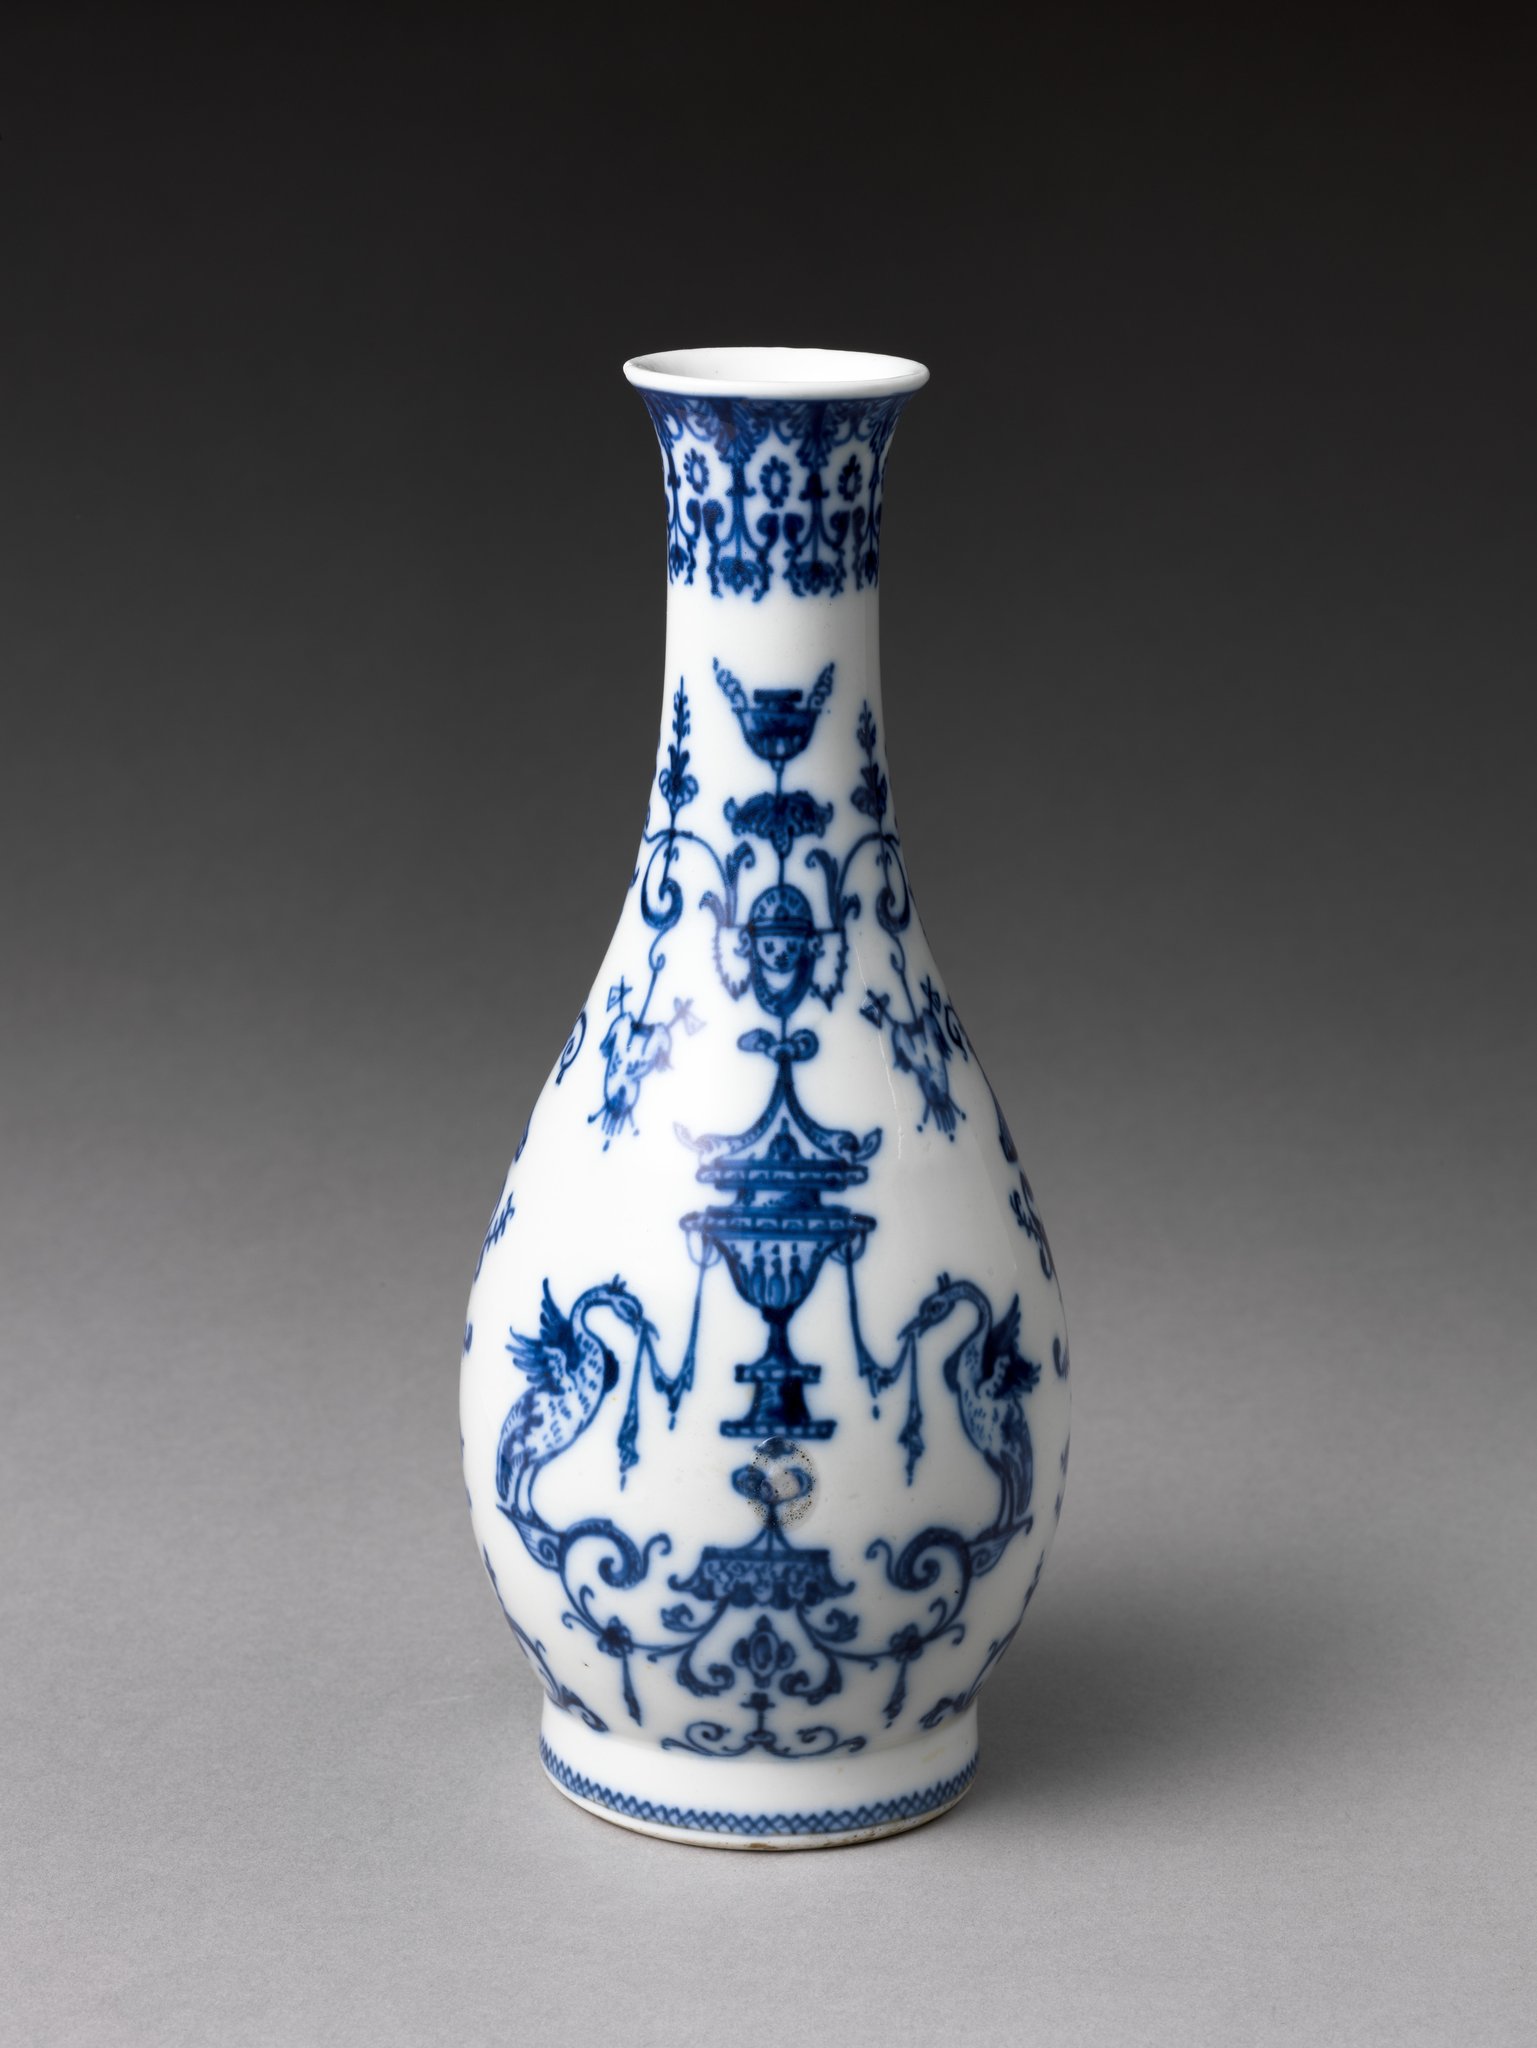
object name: vase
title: Vase (one of a pair)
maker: saint-cloud factory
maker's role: factory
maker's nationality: french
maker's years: 1693-1766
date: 1695-1700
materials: cobalt, glaze, pigment, soft paste porcelain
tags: birds